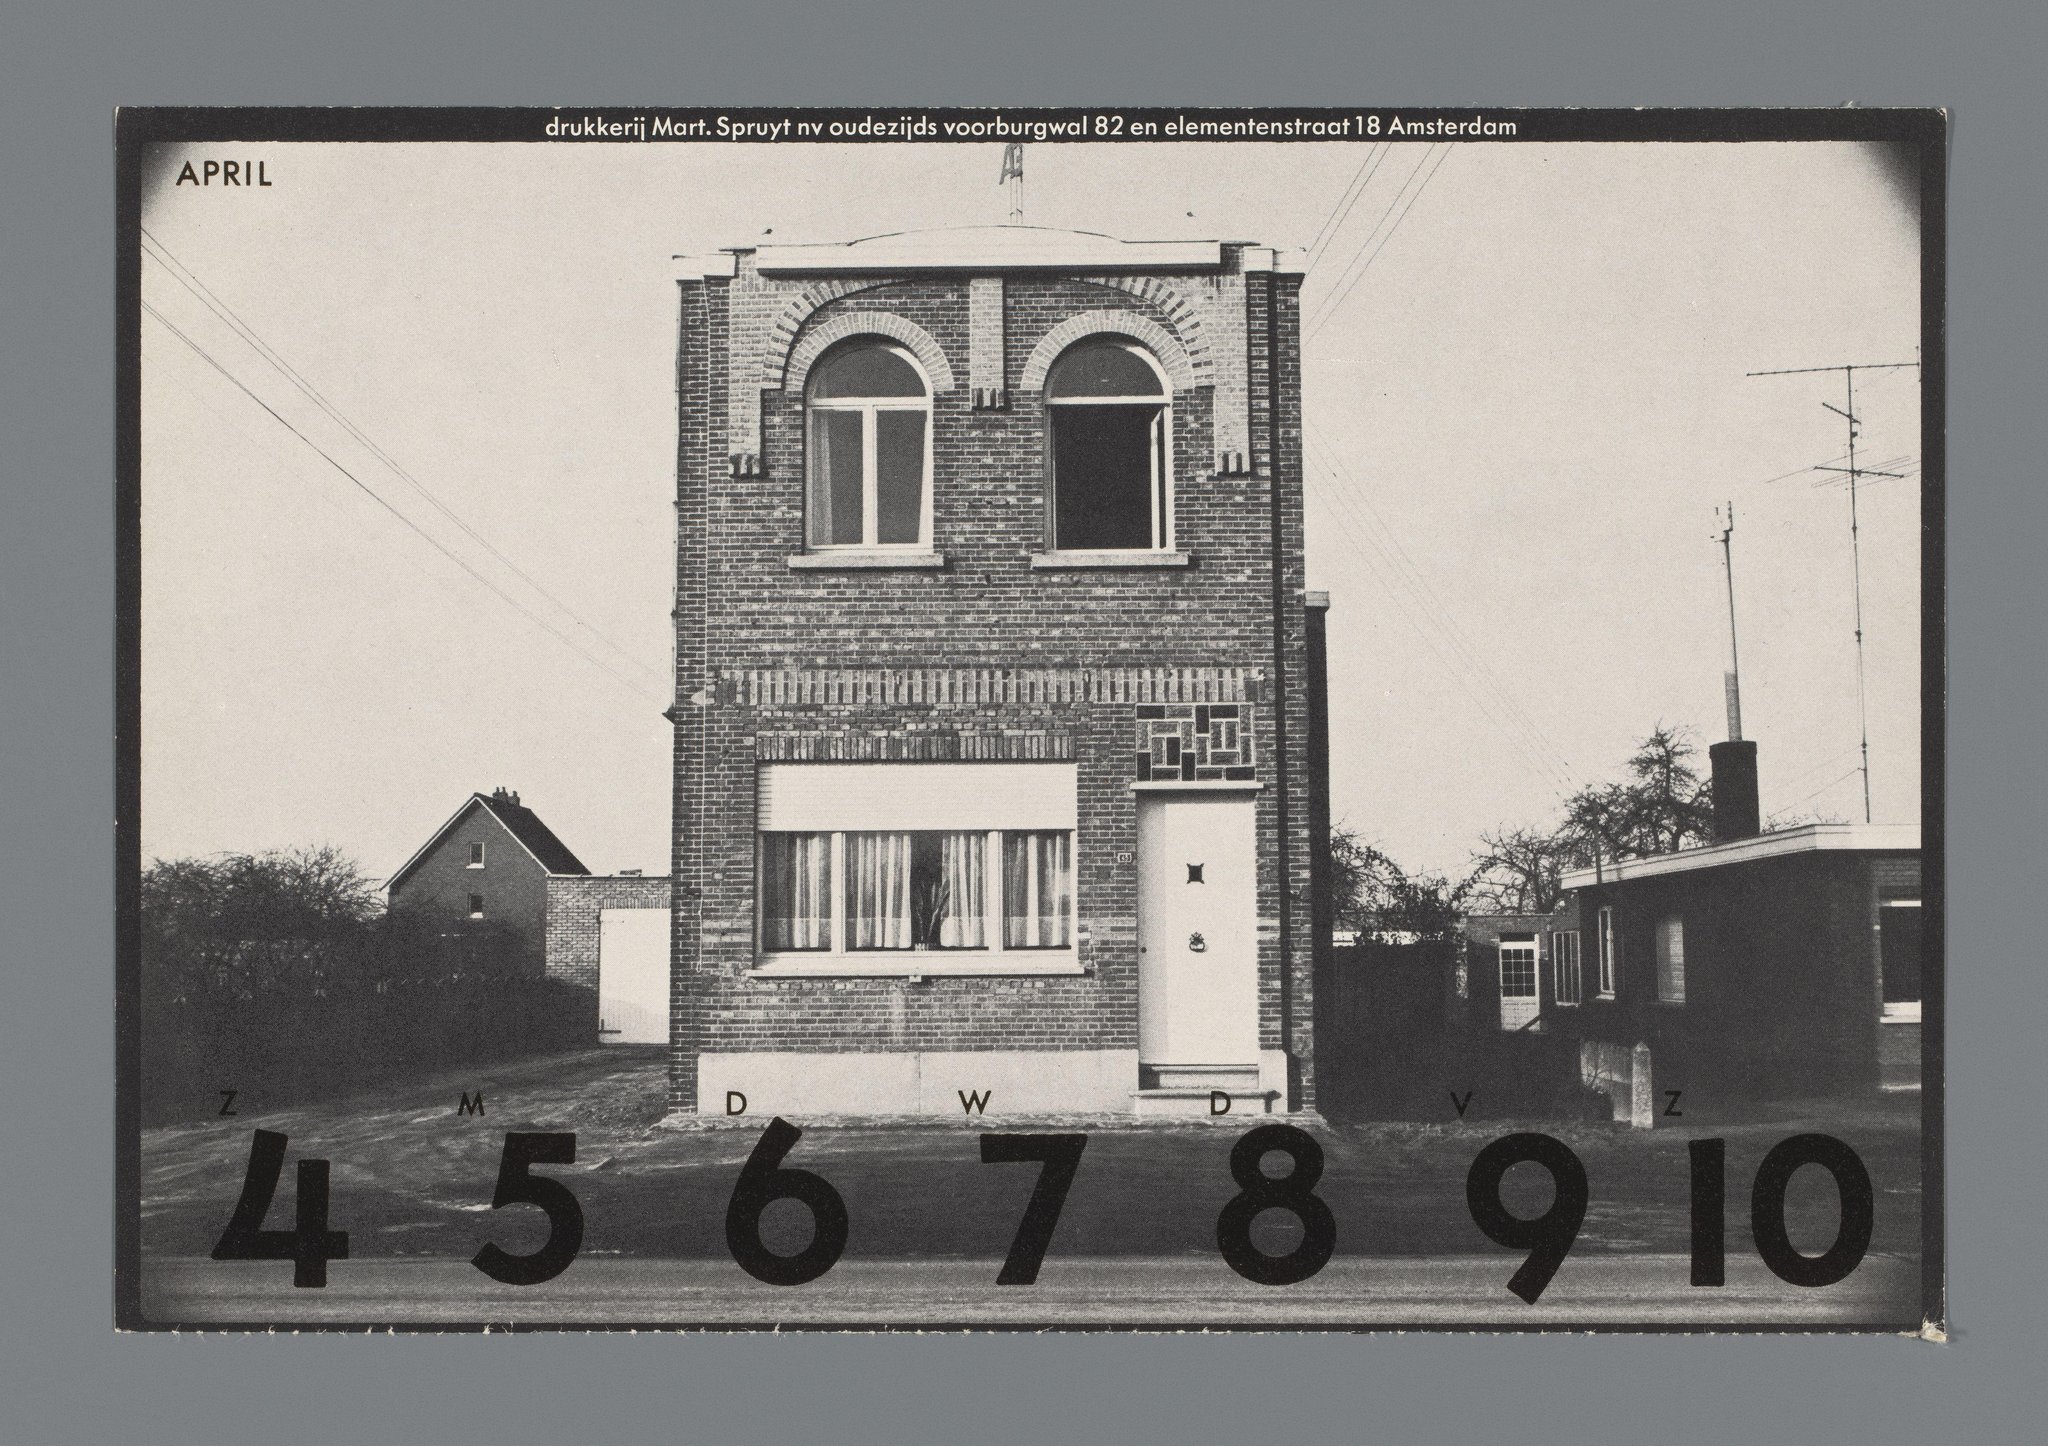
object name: photograph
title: België. Huizen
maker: Anonymous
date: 1900-1950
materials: paper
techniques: offset printed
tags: belgium